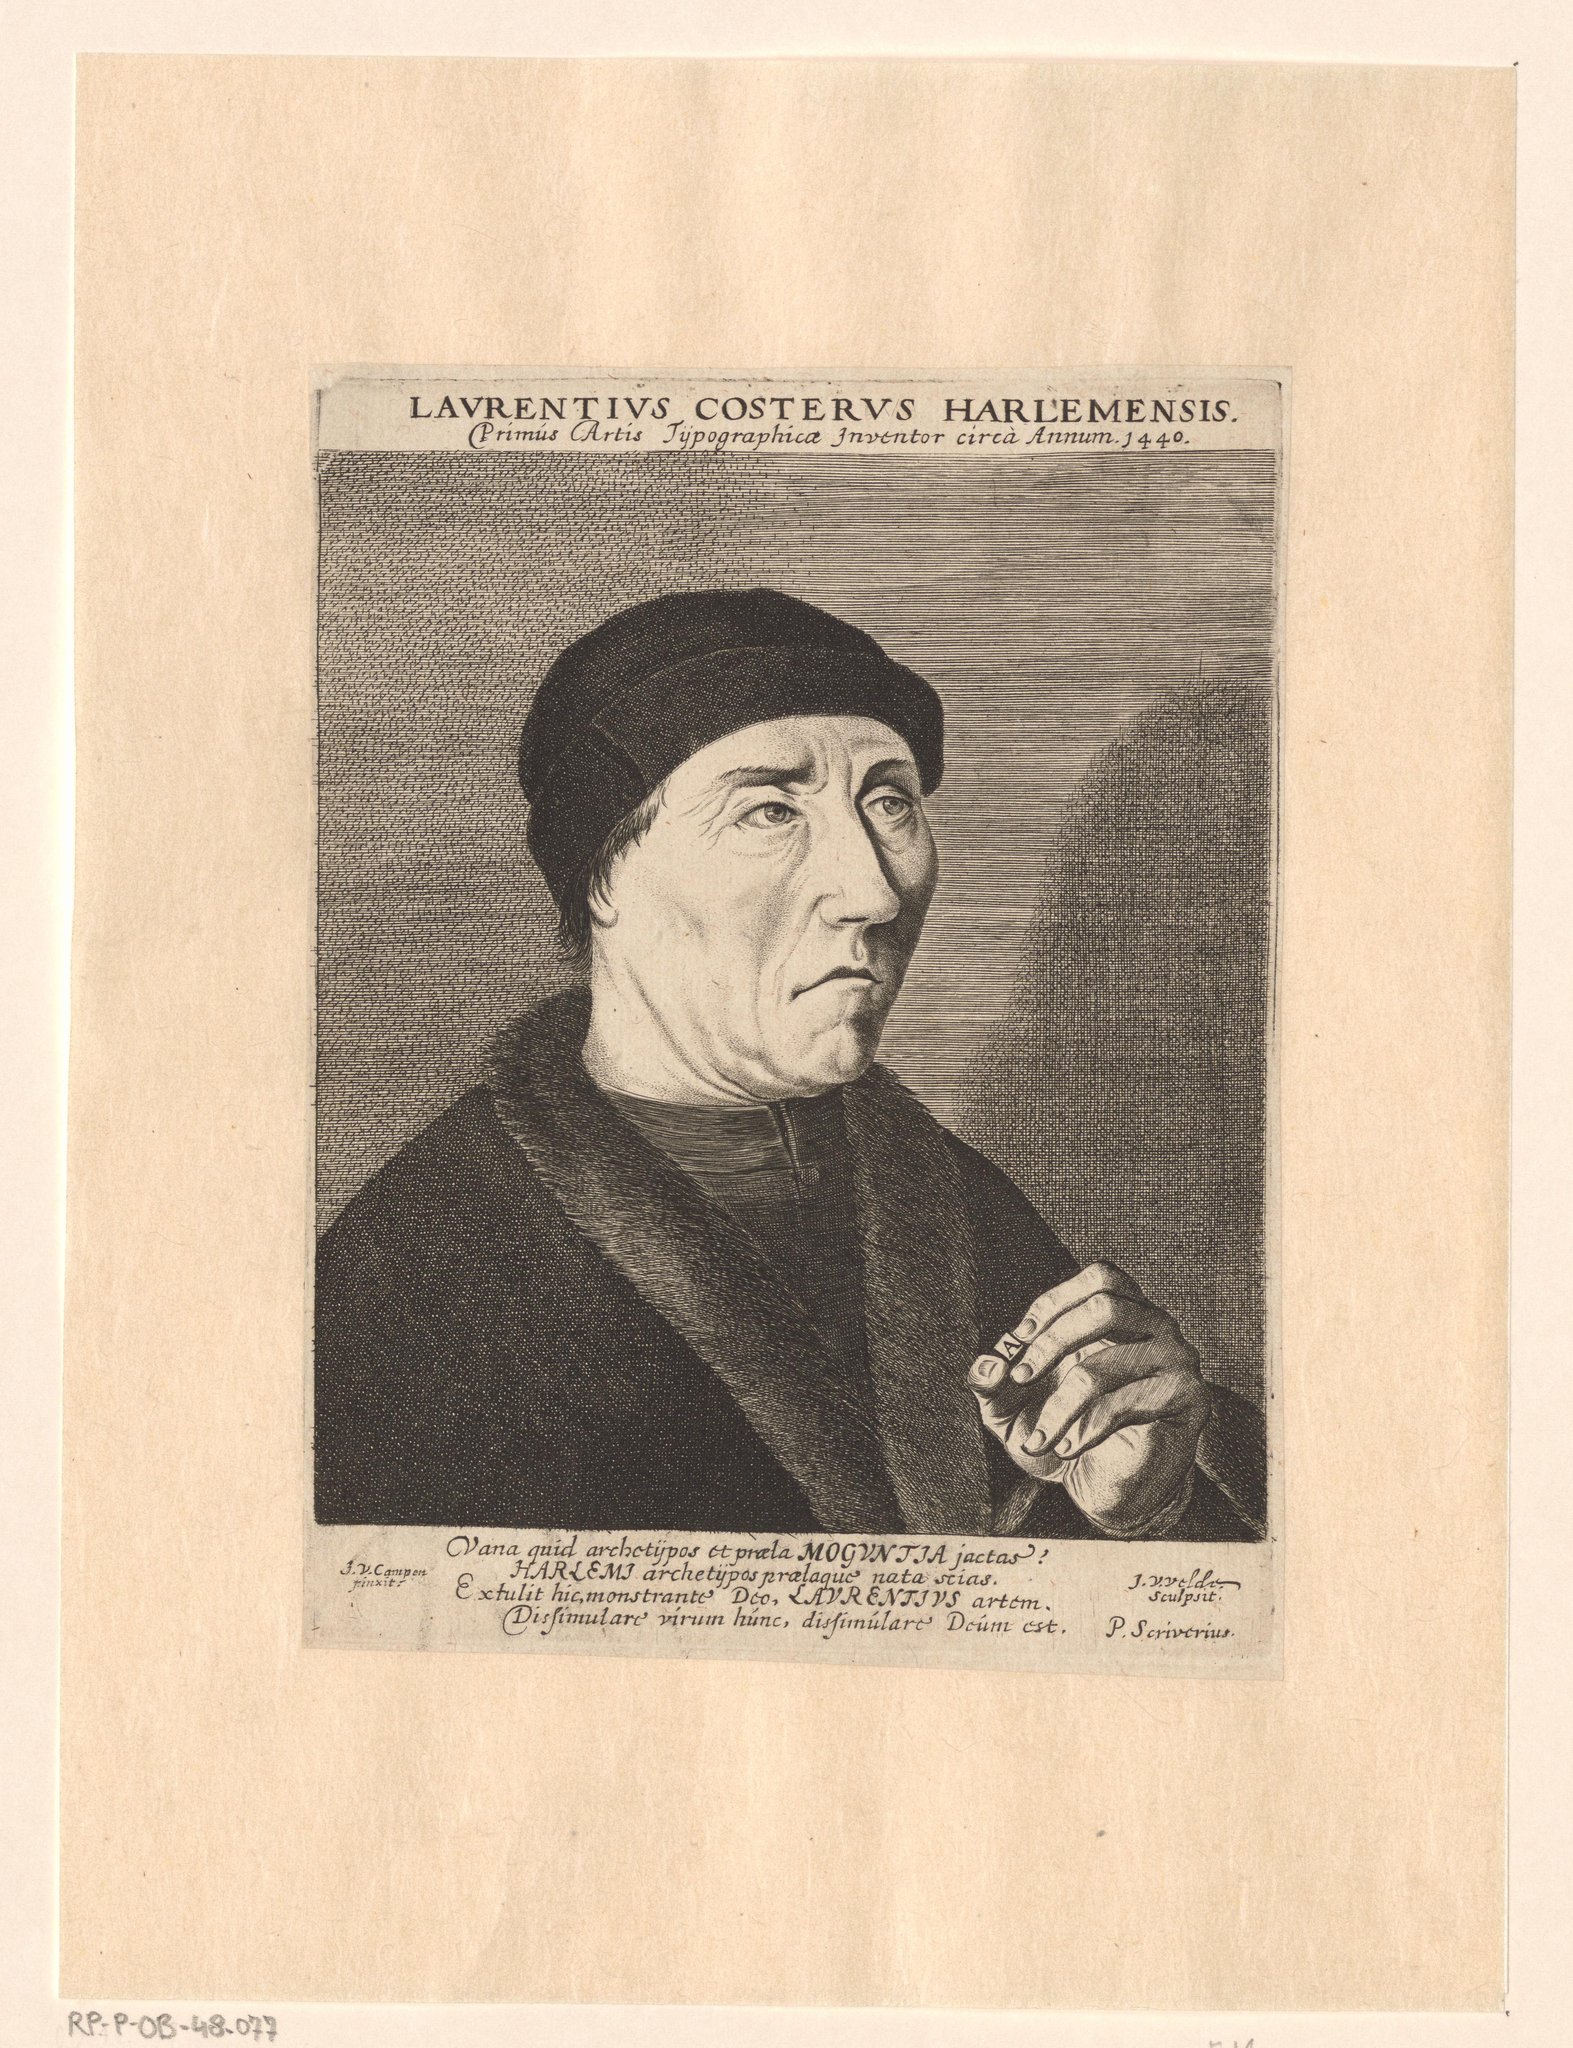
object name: print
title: Portret van Laurens Janszoon Coster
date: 1628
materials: paper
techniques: engraving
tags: historical persons, tools, implements of printer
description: Prent mogelijk uit: Ampzing, Samuel. Beschryvinge ende lof der stad Haerlem in Holland […]. Haarlem: Adriaen Roman (I), 1628.